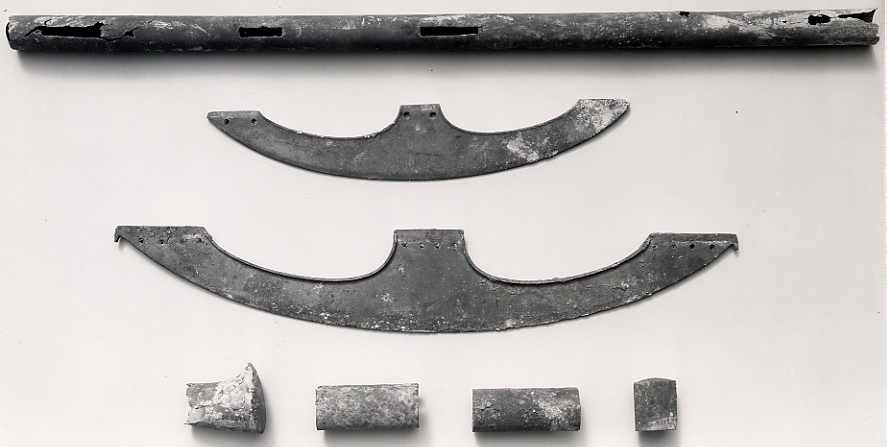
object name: ax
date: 1981-1802 BCE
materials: bronze, copper alloy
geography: egypt